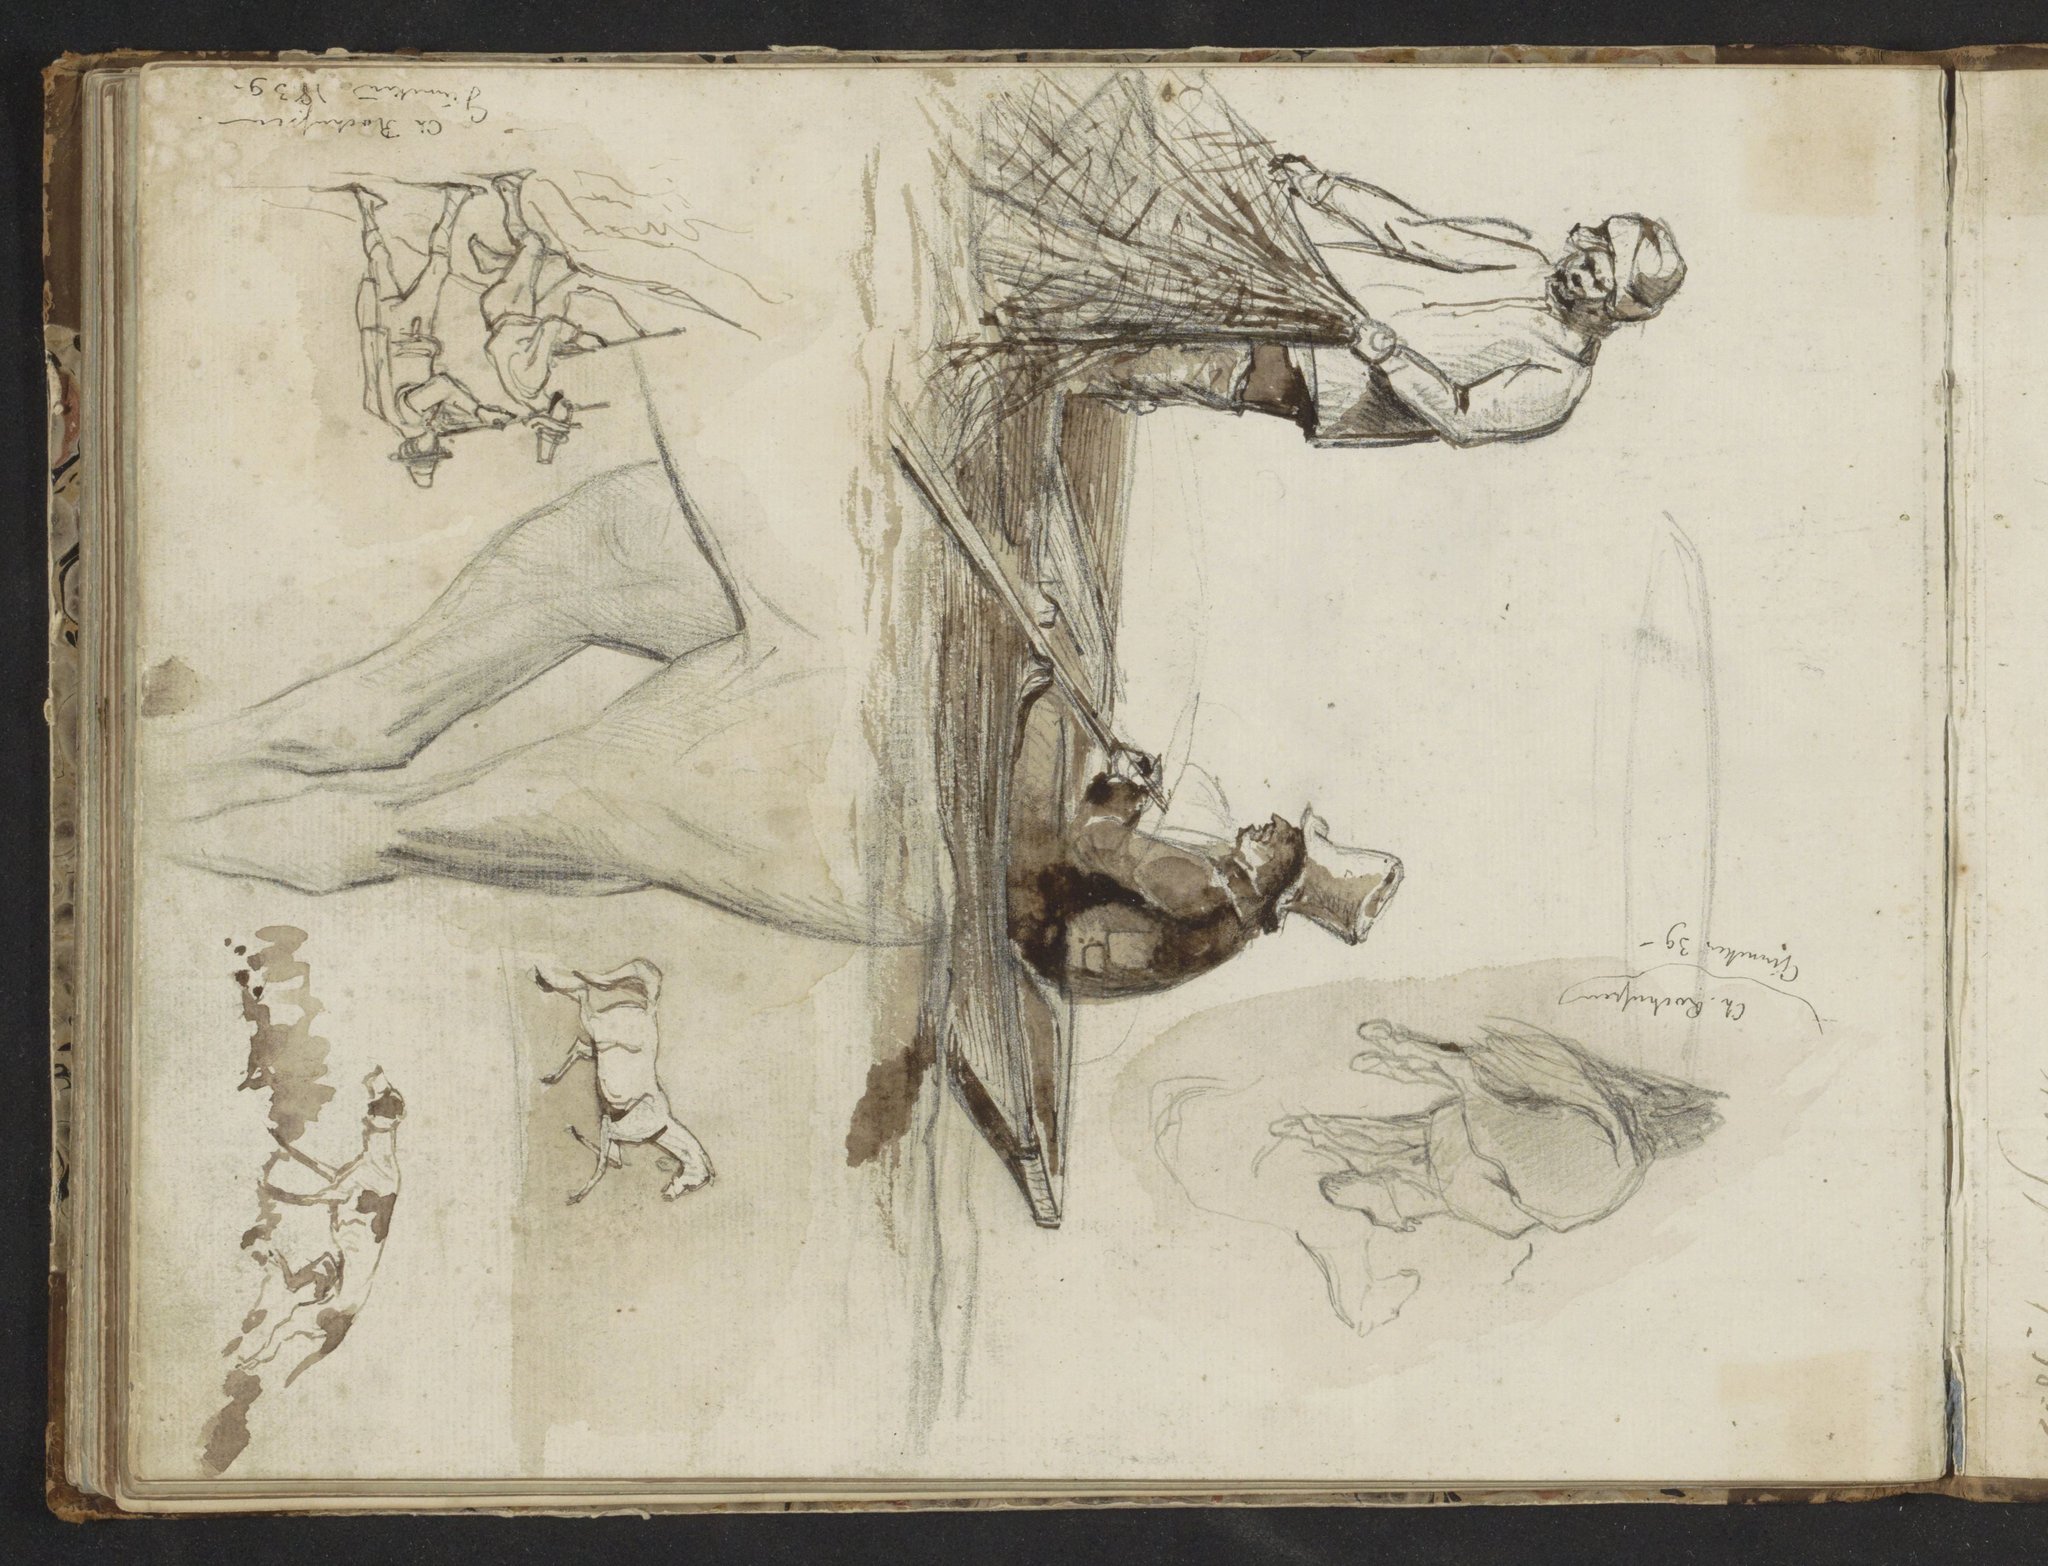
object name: sketchbook leaf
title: Vissers in een boot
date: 1839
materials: ink, paper, pencil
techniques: brush, pen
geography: ginneken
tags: hunter, horse, fisherman, dog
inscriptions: date and inscription: ‘Ch. Rochussen/ Ginneken 39-/ Ch. Rochussen/ Ginneken 1839-’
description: Tevens studies van honden, paarden en jagers. Blad 41 verso uit een schetsboek met 41 bladen.